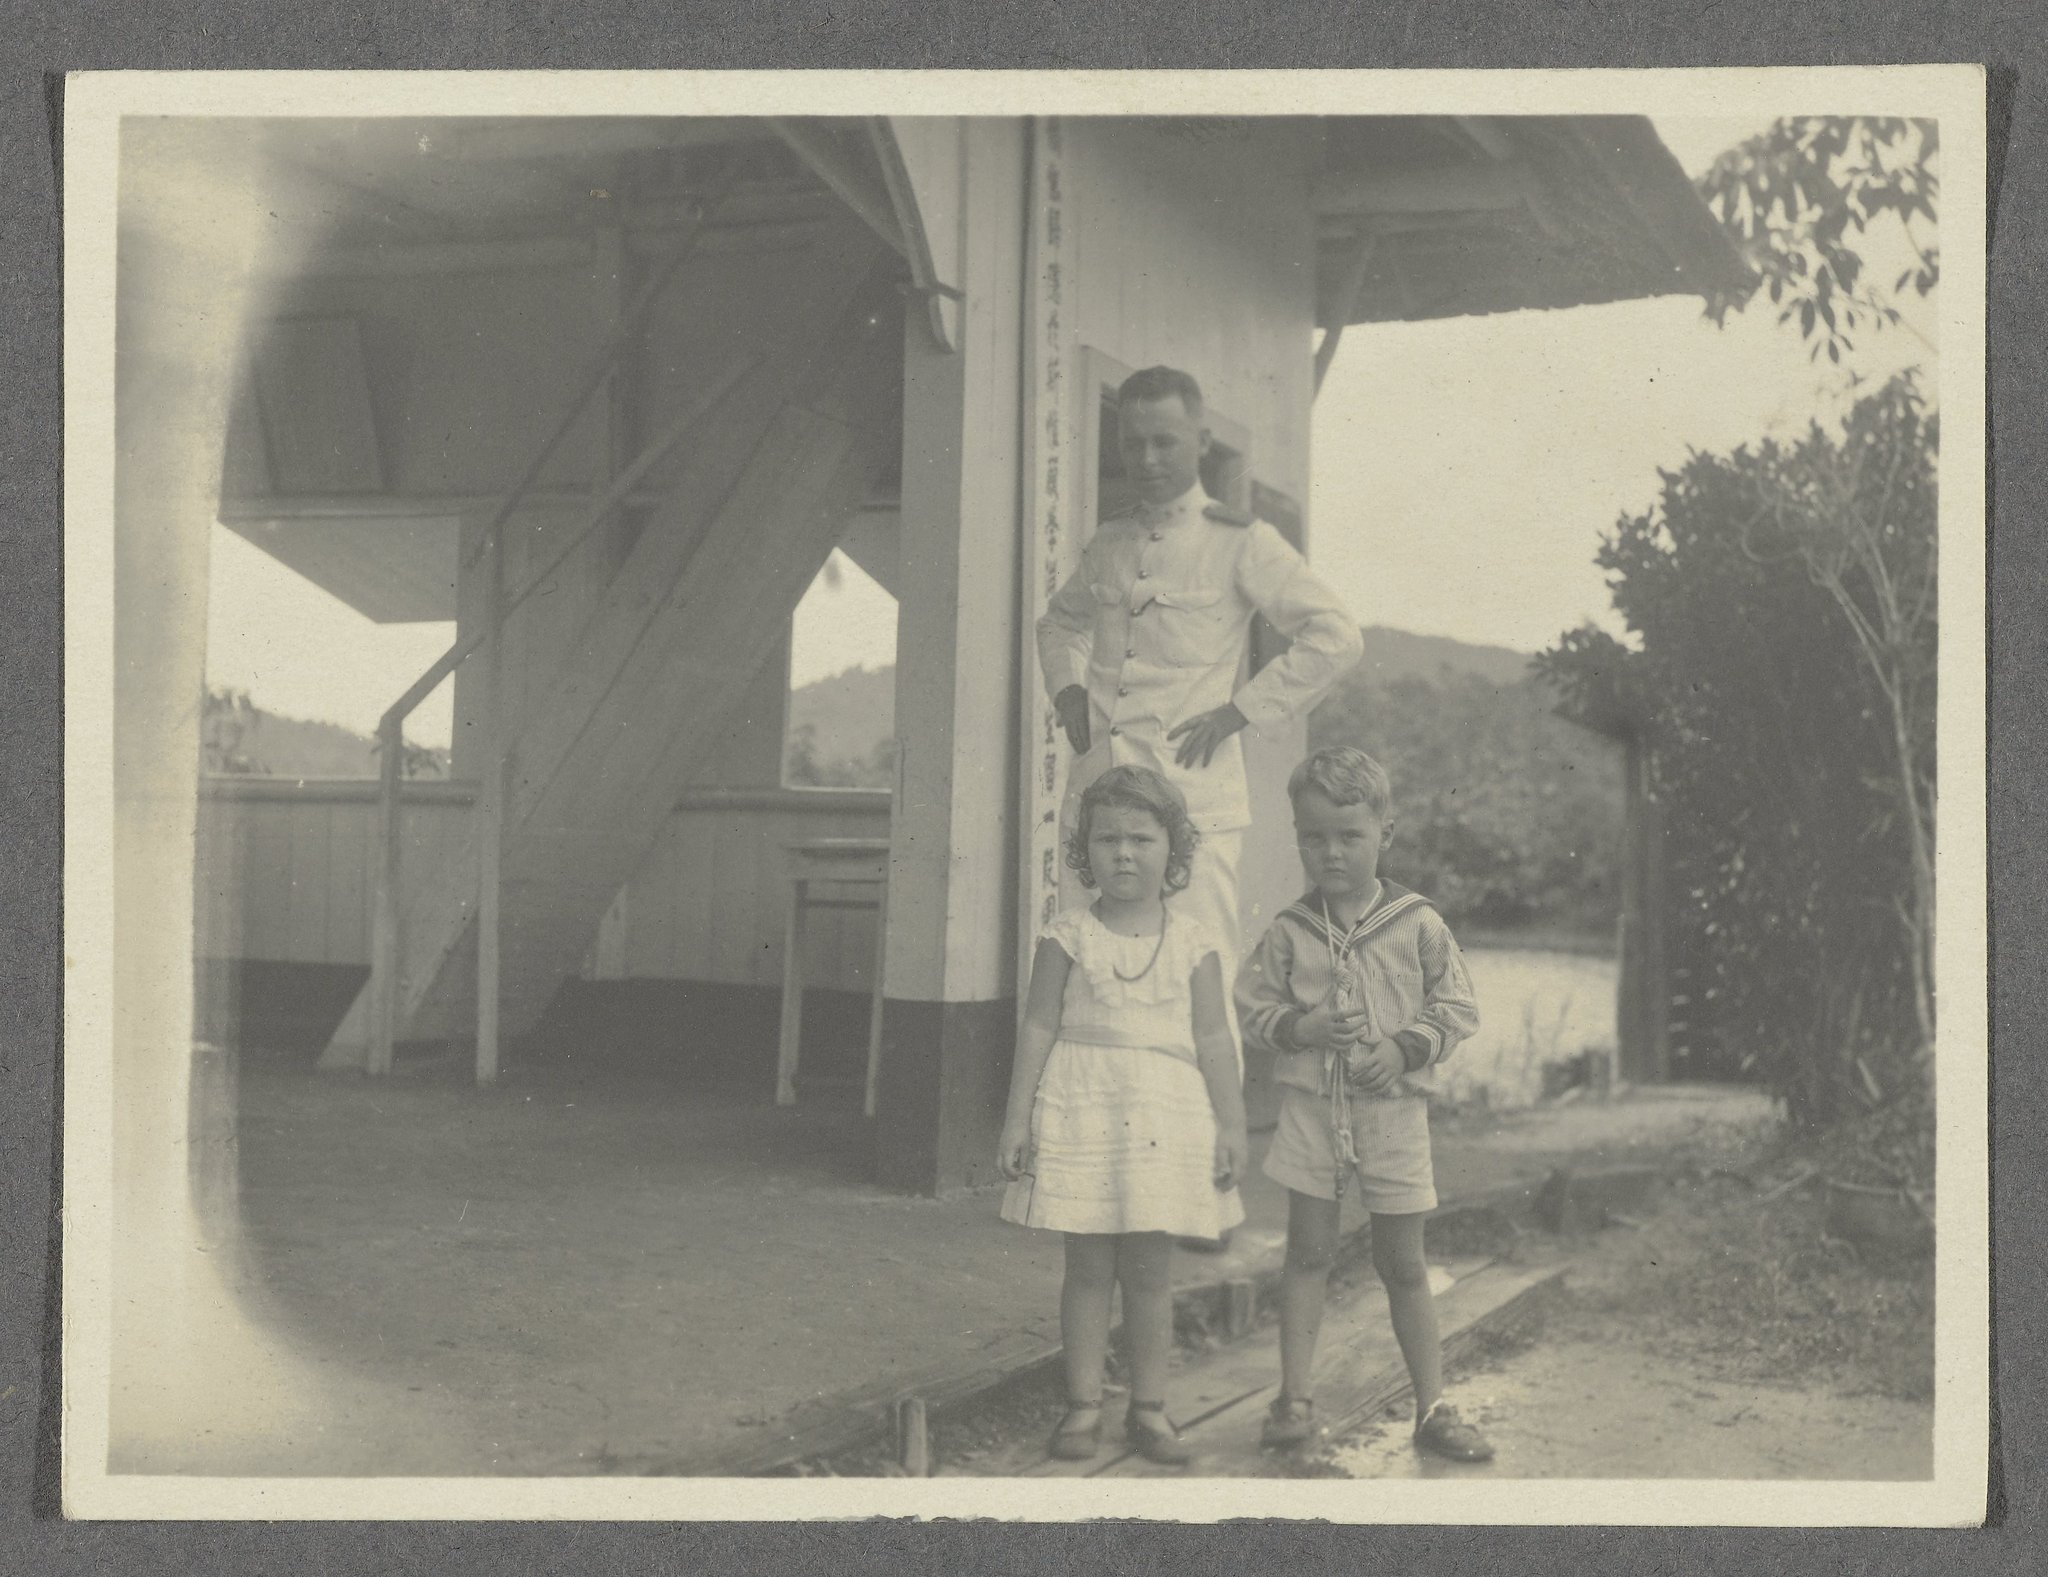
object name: photograph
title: Klaas Kleiterp en zijn kinderen Tiny en Klaas bij een huis Monterado op Borneo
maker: klaas kleiterp (i)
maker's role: arts, officier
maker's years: 1892-1943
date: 1907-1924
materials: paper, photographic support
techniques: gelatin silver print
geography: monterado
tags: (military) uniforms, father and child(ren), man and child(ren) (family group), dutch east indies, the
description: Onderdeel van Fotoalbum van de familie Kleiterp-Vermeulen met opnames van de kinderen Klaas en Tiny in Nederlands-Indië.